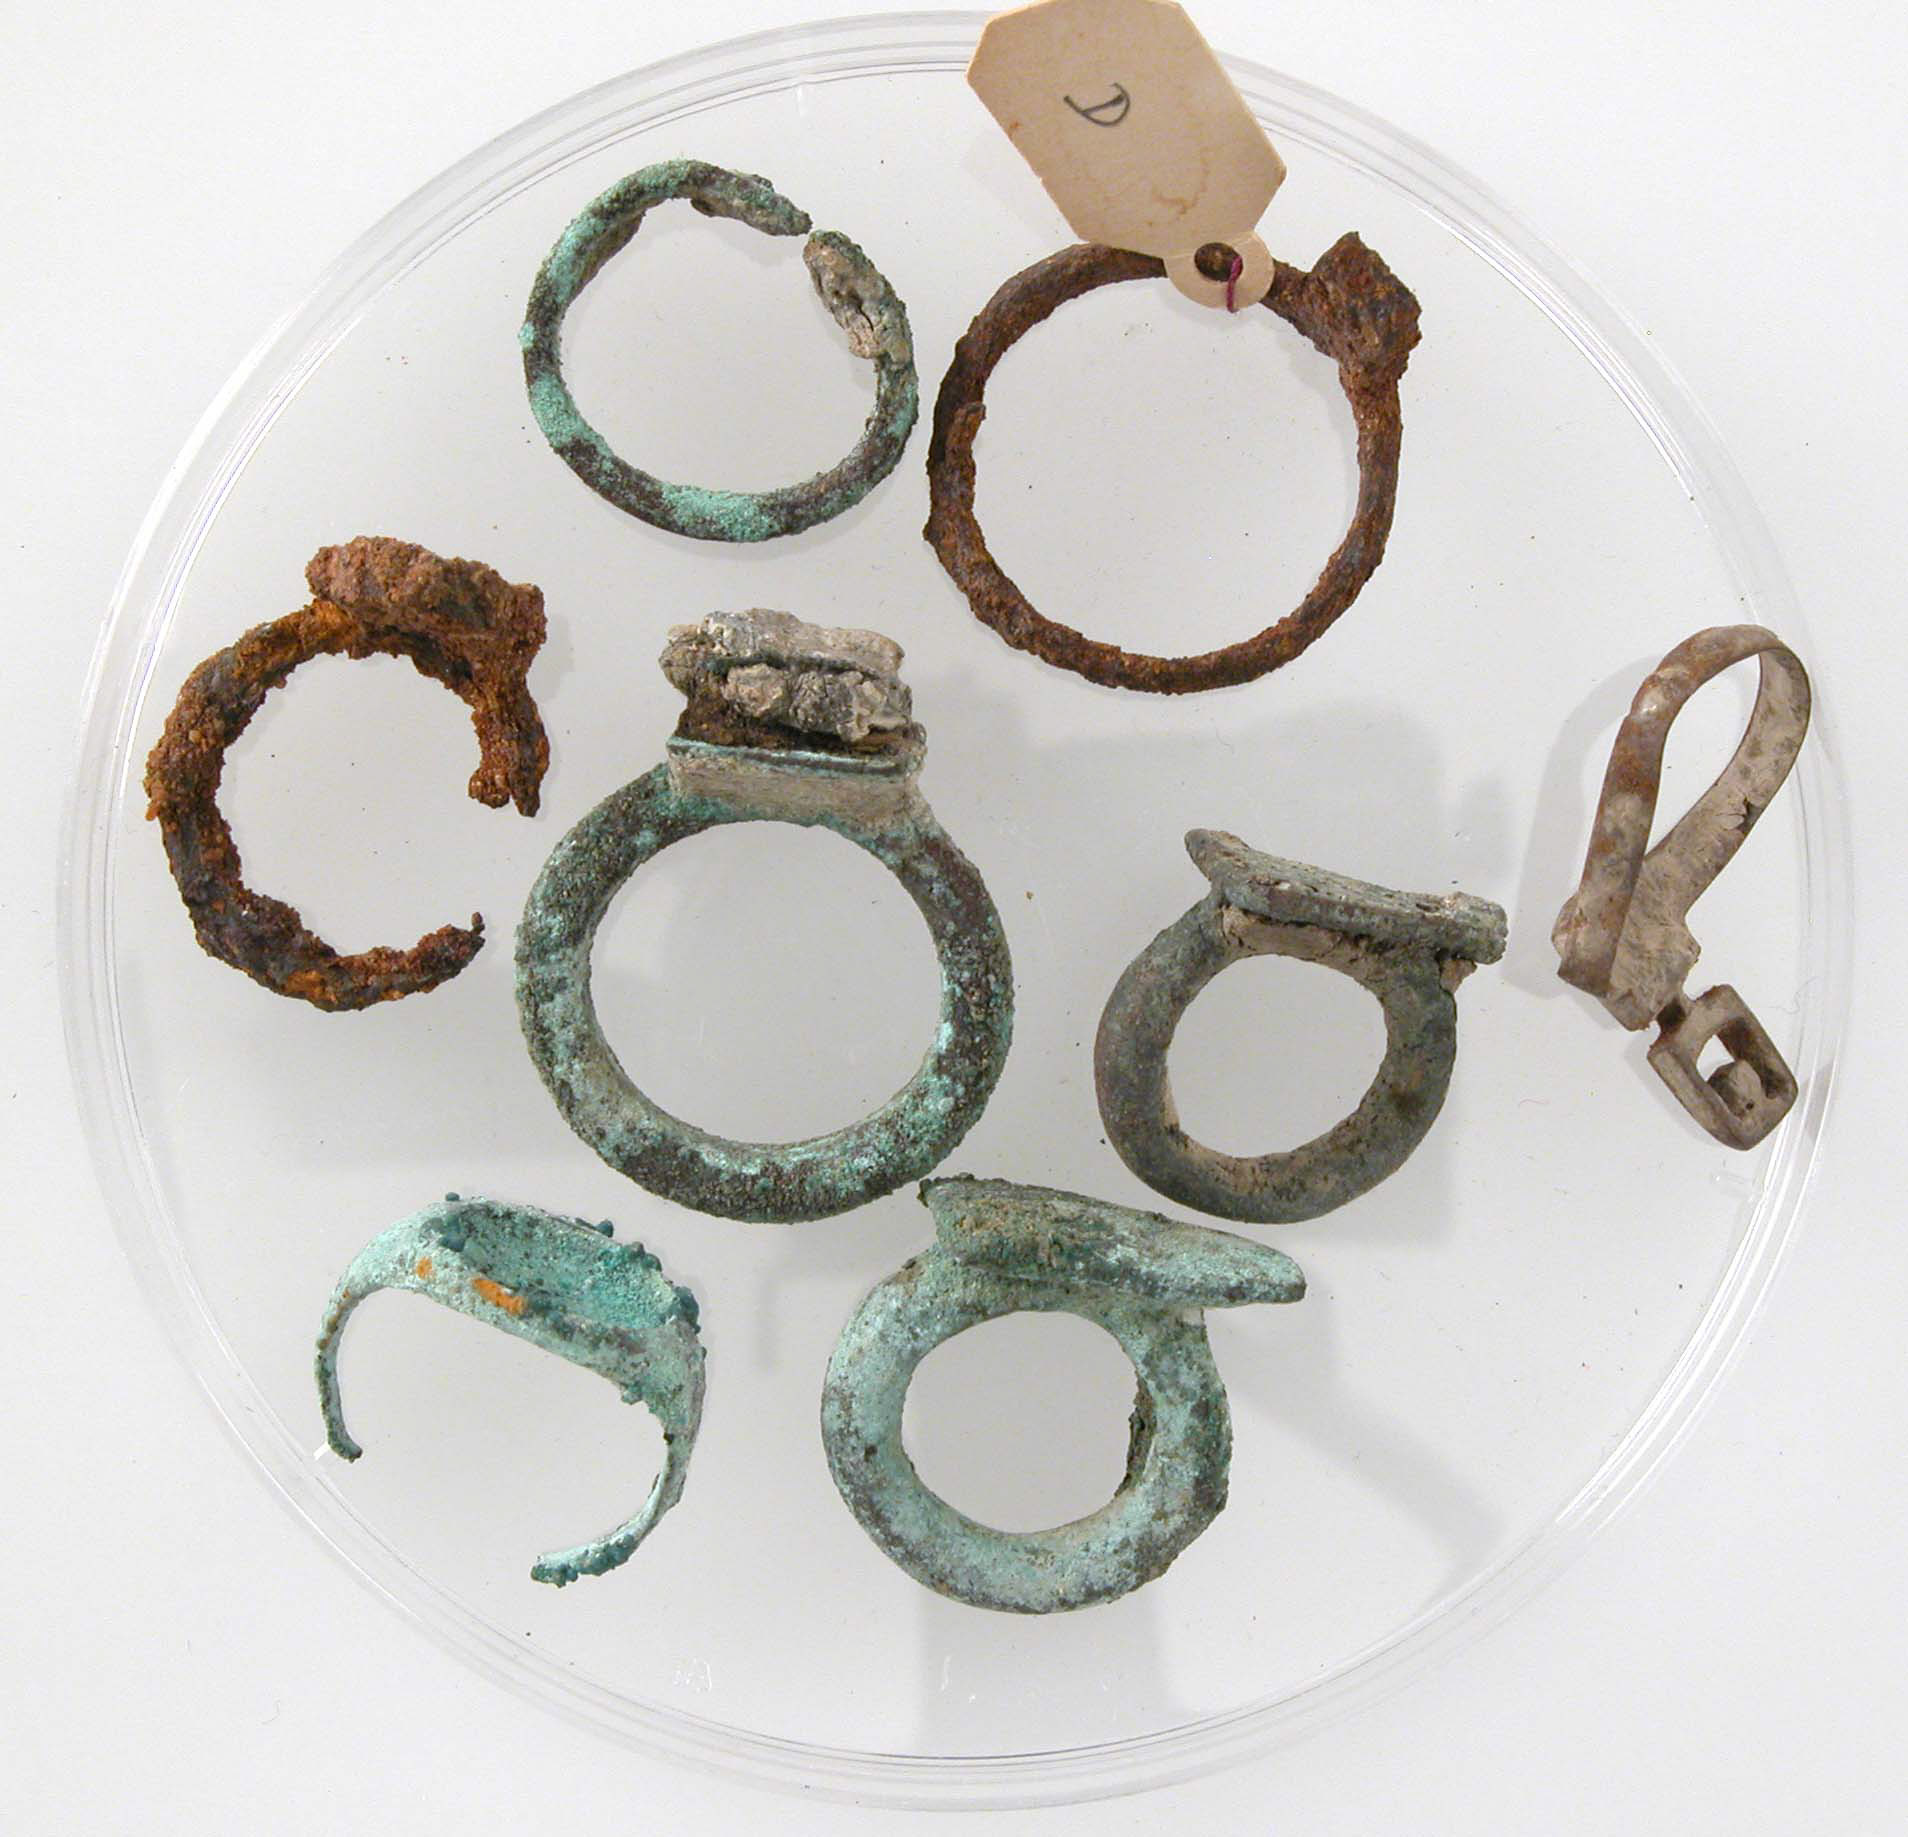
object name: ring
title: Finger Rings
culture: coptic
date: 301-700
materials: copper alloy, iron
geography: egypt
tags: rings